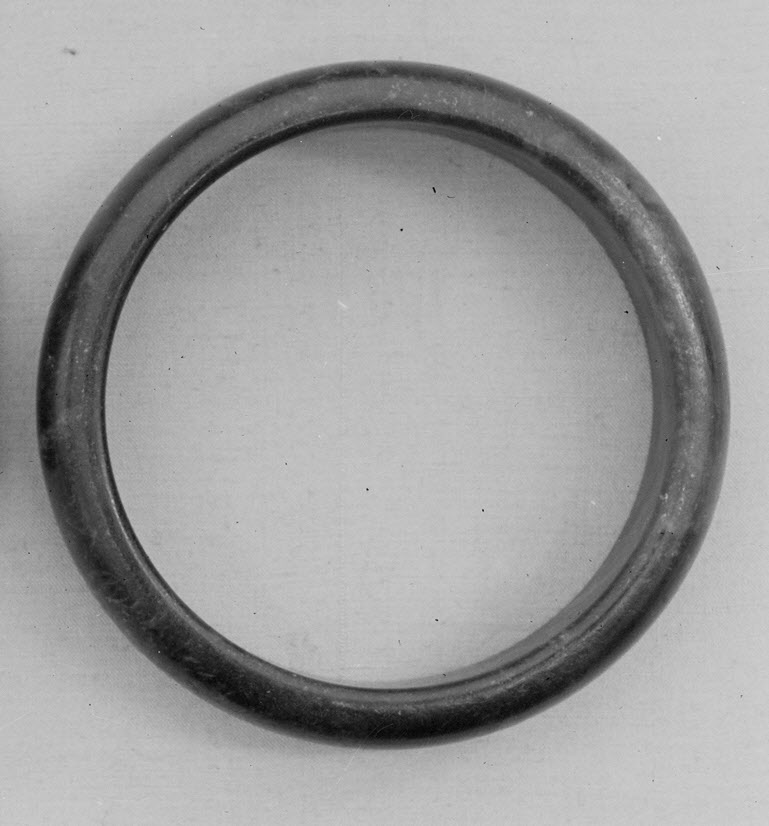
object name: bracelet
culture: chinese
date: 206 BCE-220 CE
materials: jade